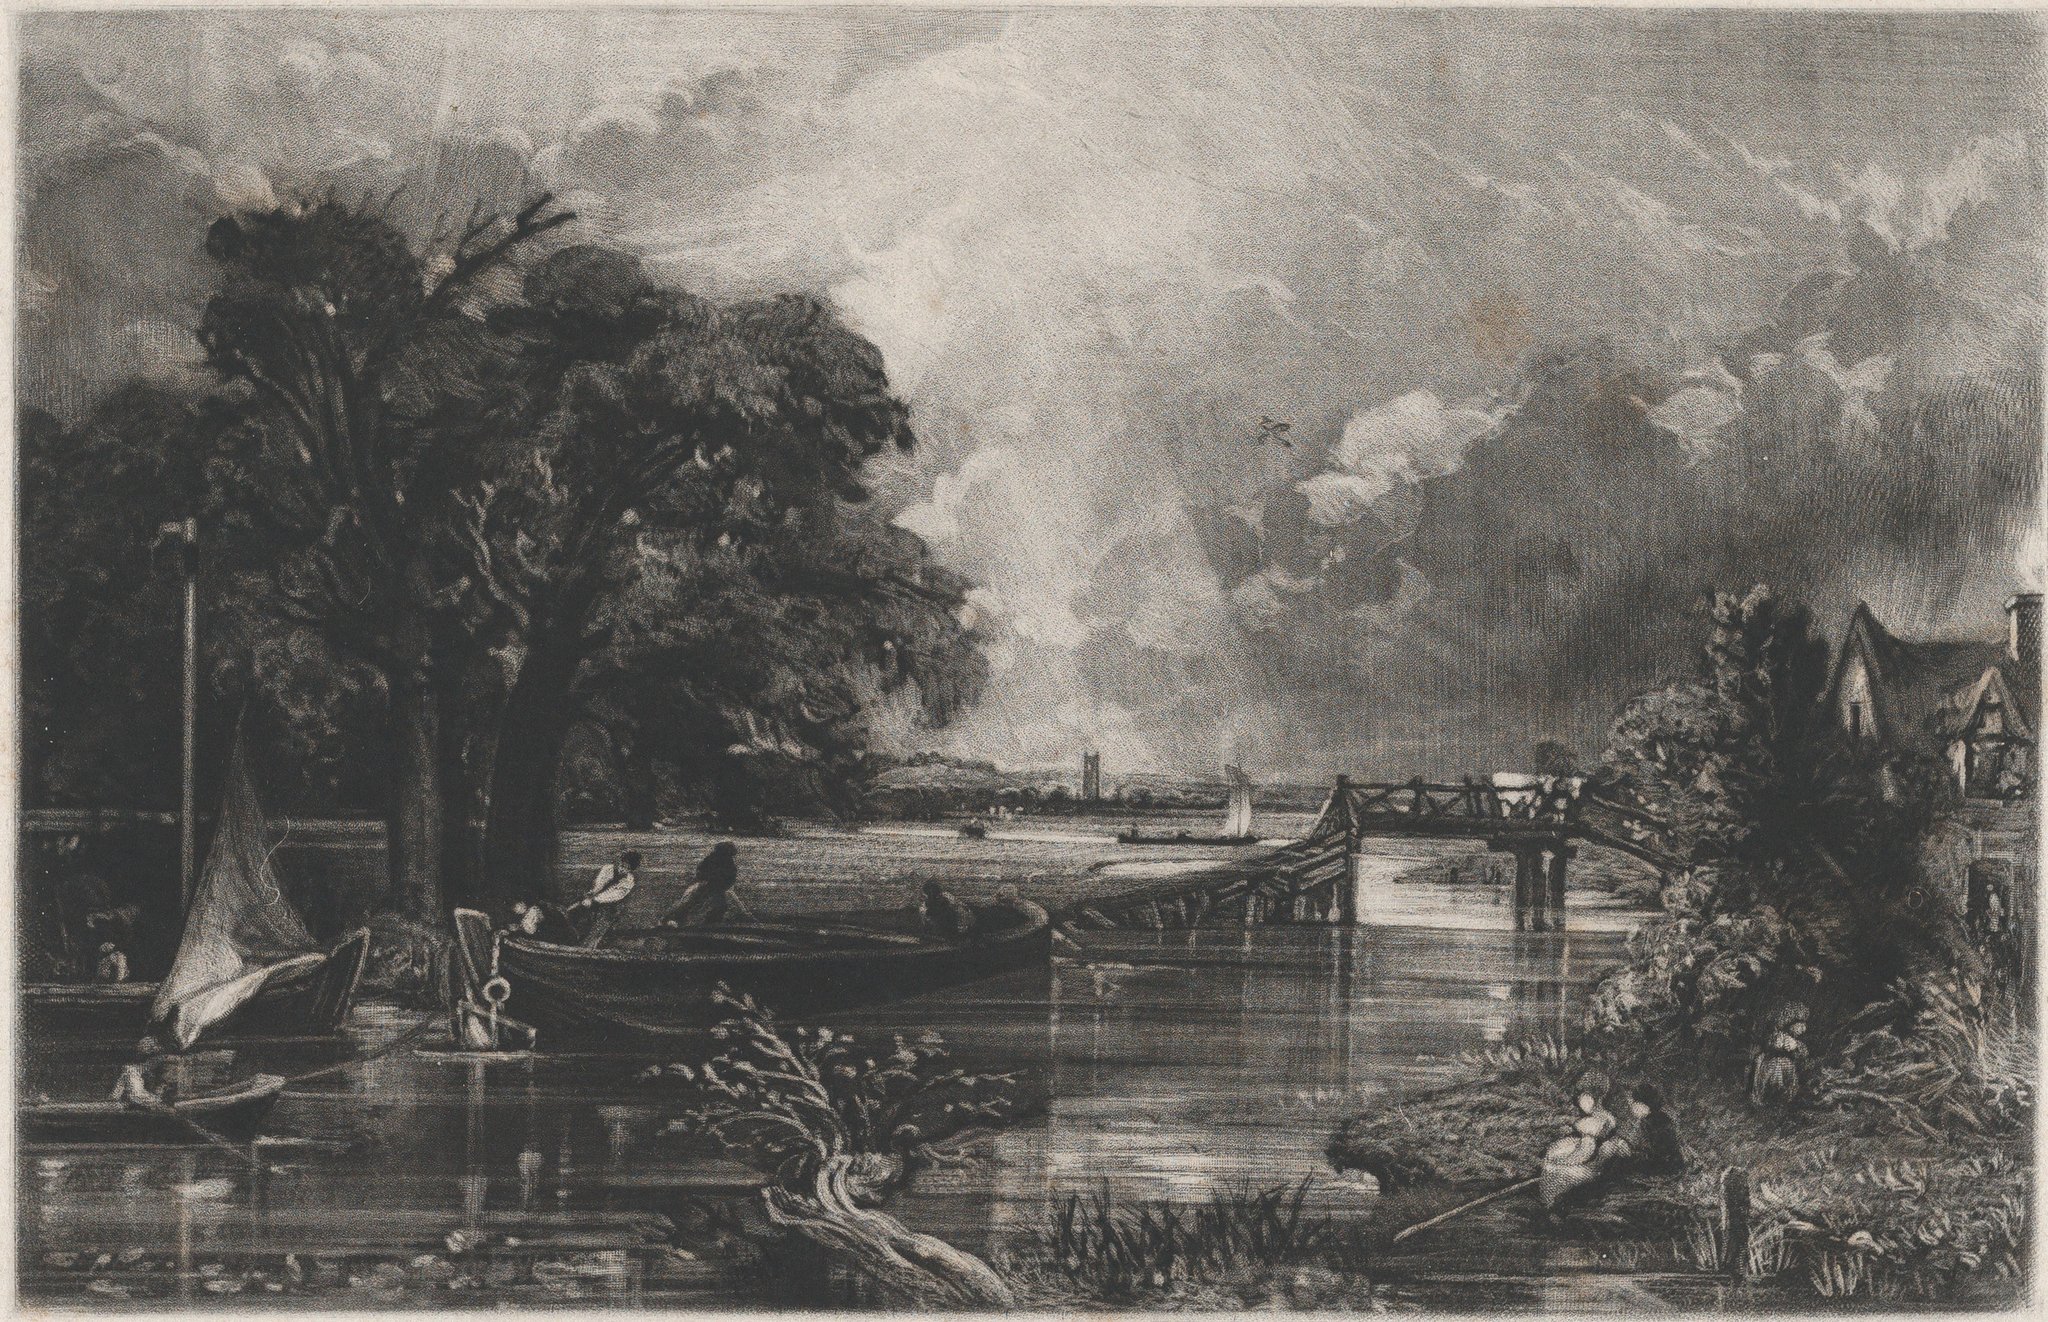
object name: print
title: River Stour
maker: david lucas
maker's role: artist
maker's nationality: british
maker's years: 1802-1881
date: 1830-1831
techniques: mezzotint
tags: bridges,men,rivers,trees,boats